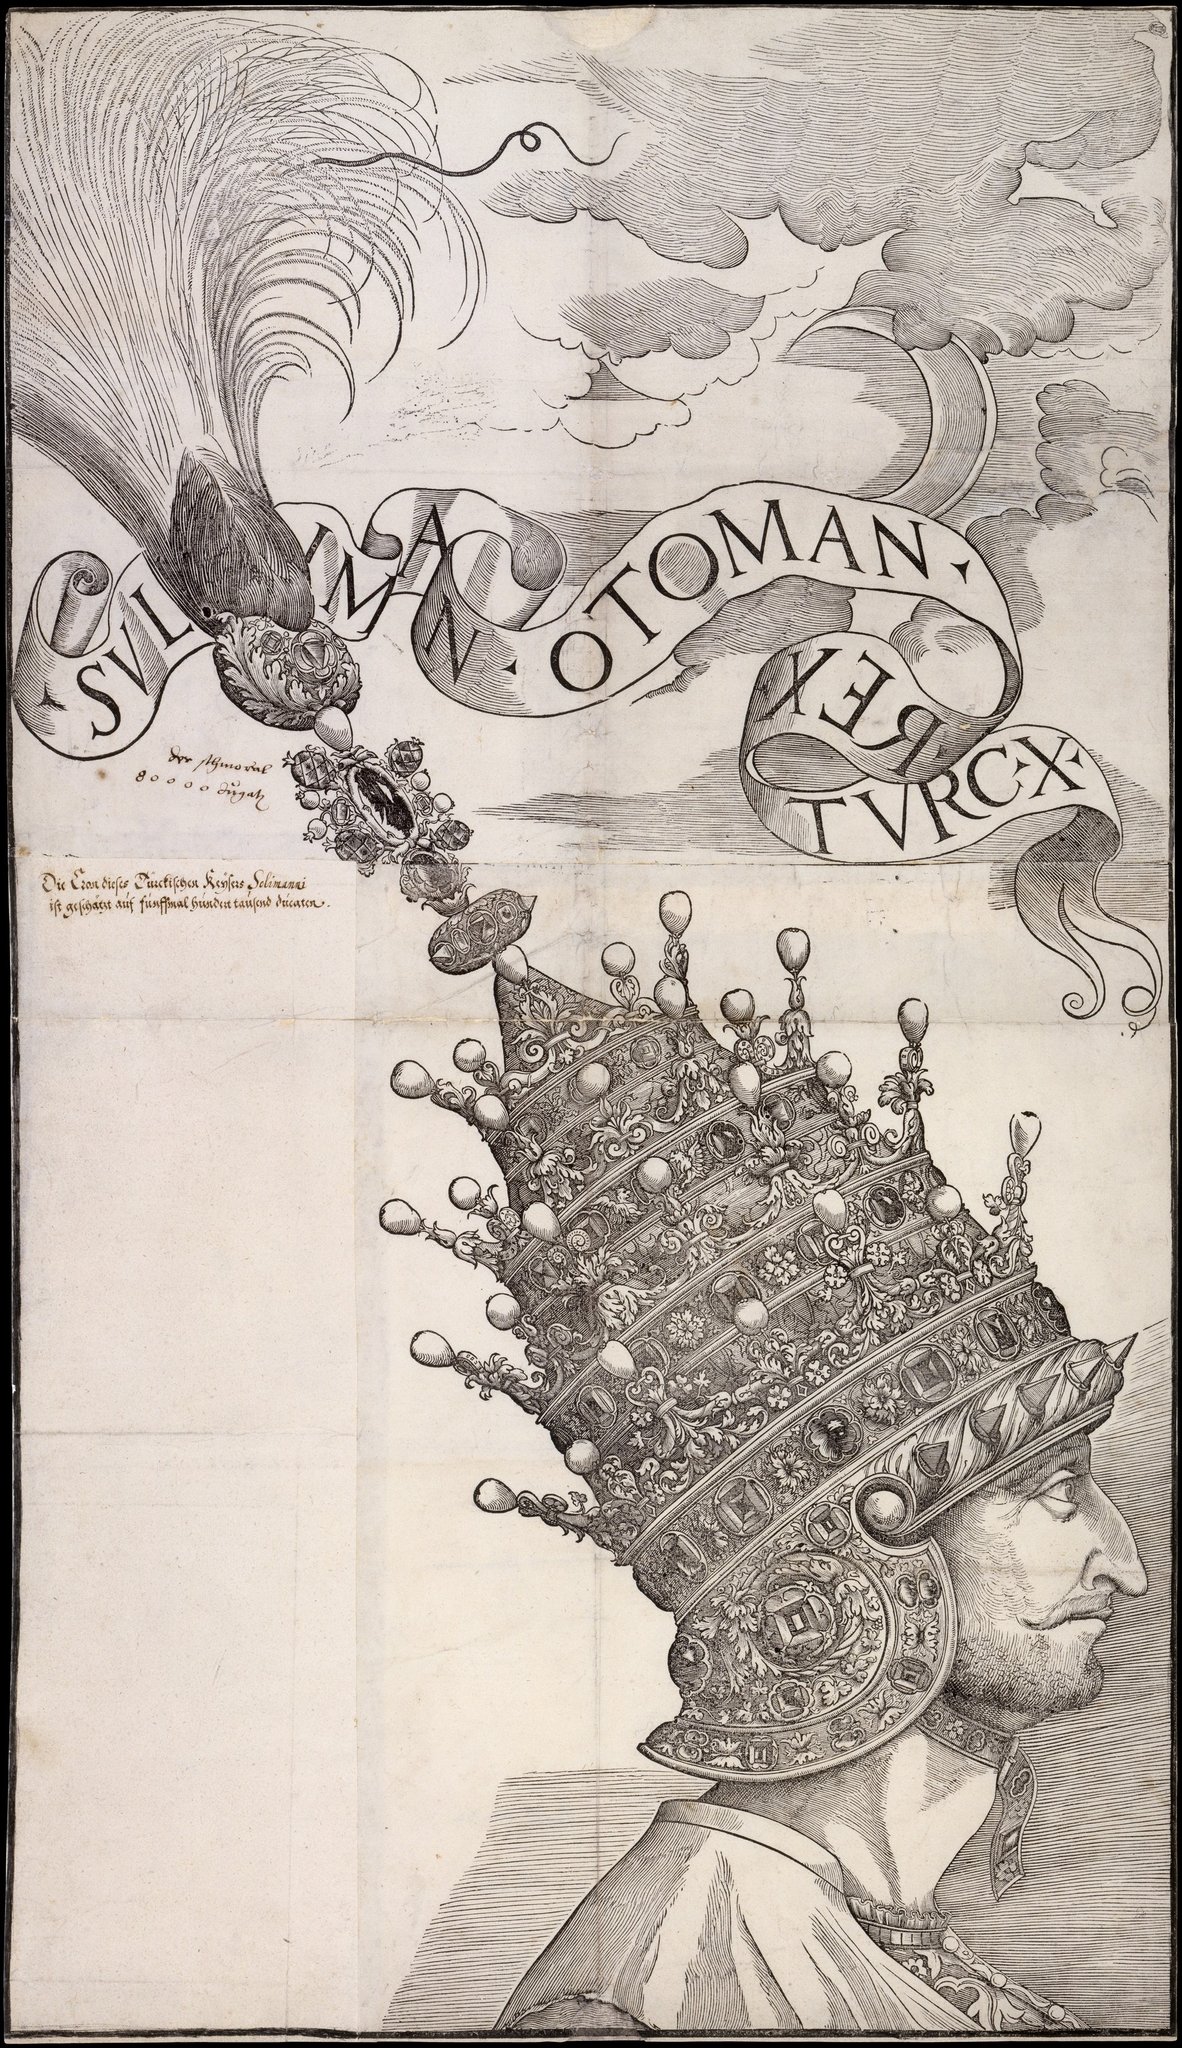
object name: print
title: Sultan Suleyman the Magnificent Wearing the Jewel-Studded Helmet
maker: anonymous, italian, venetian, 16th century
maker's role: artist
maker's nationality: italian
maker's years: 1500-1600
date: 1540-1550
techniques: woodcut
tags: helmets,men